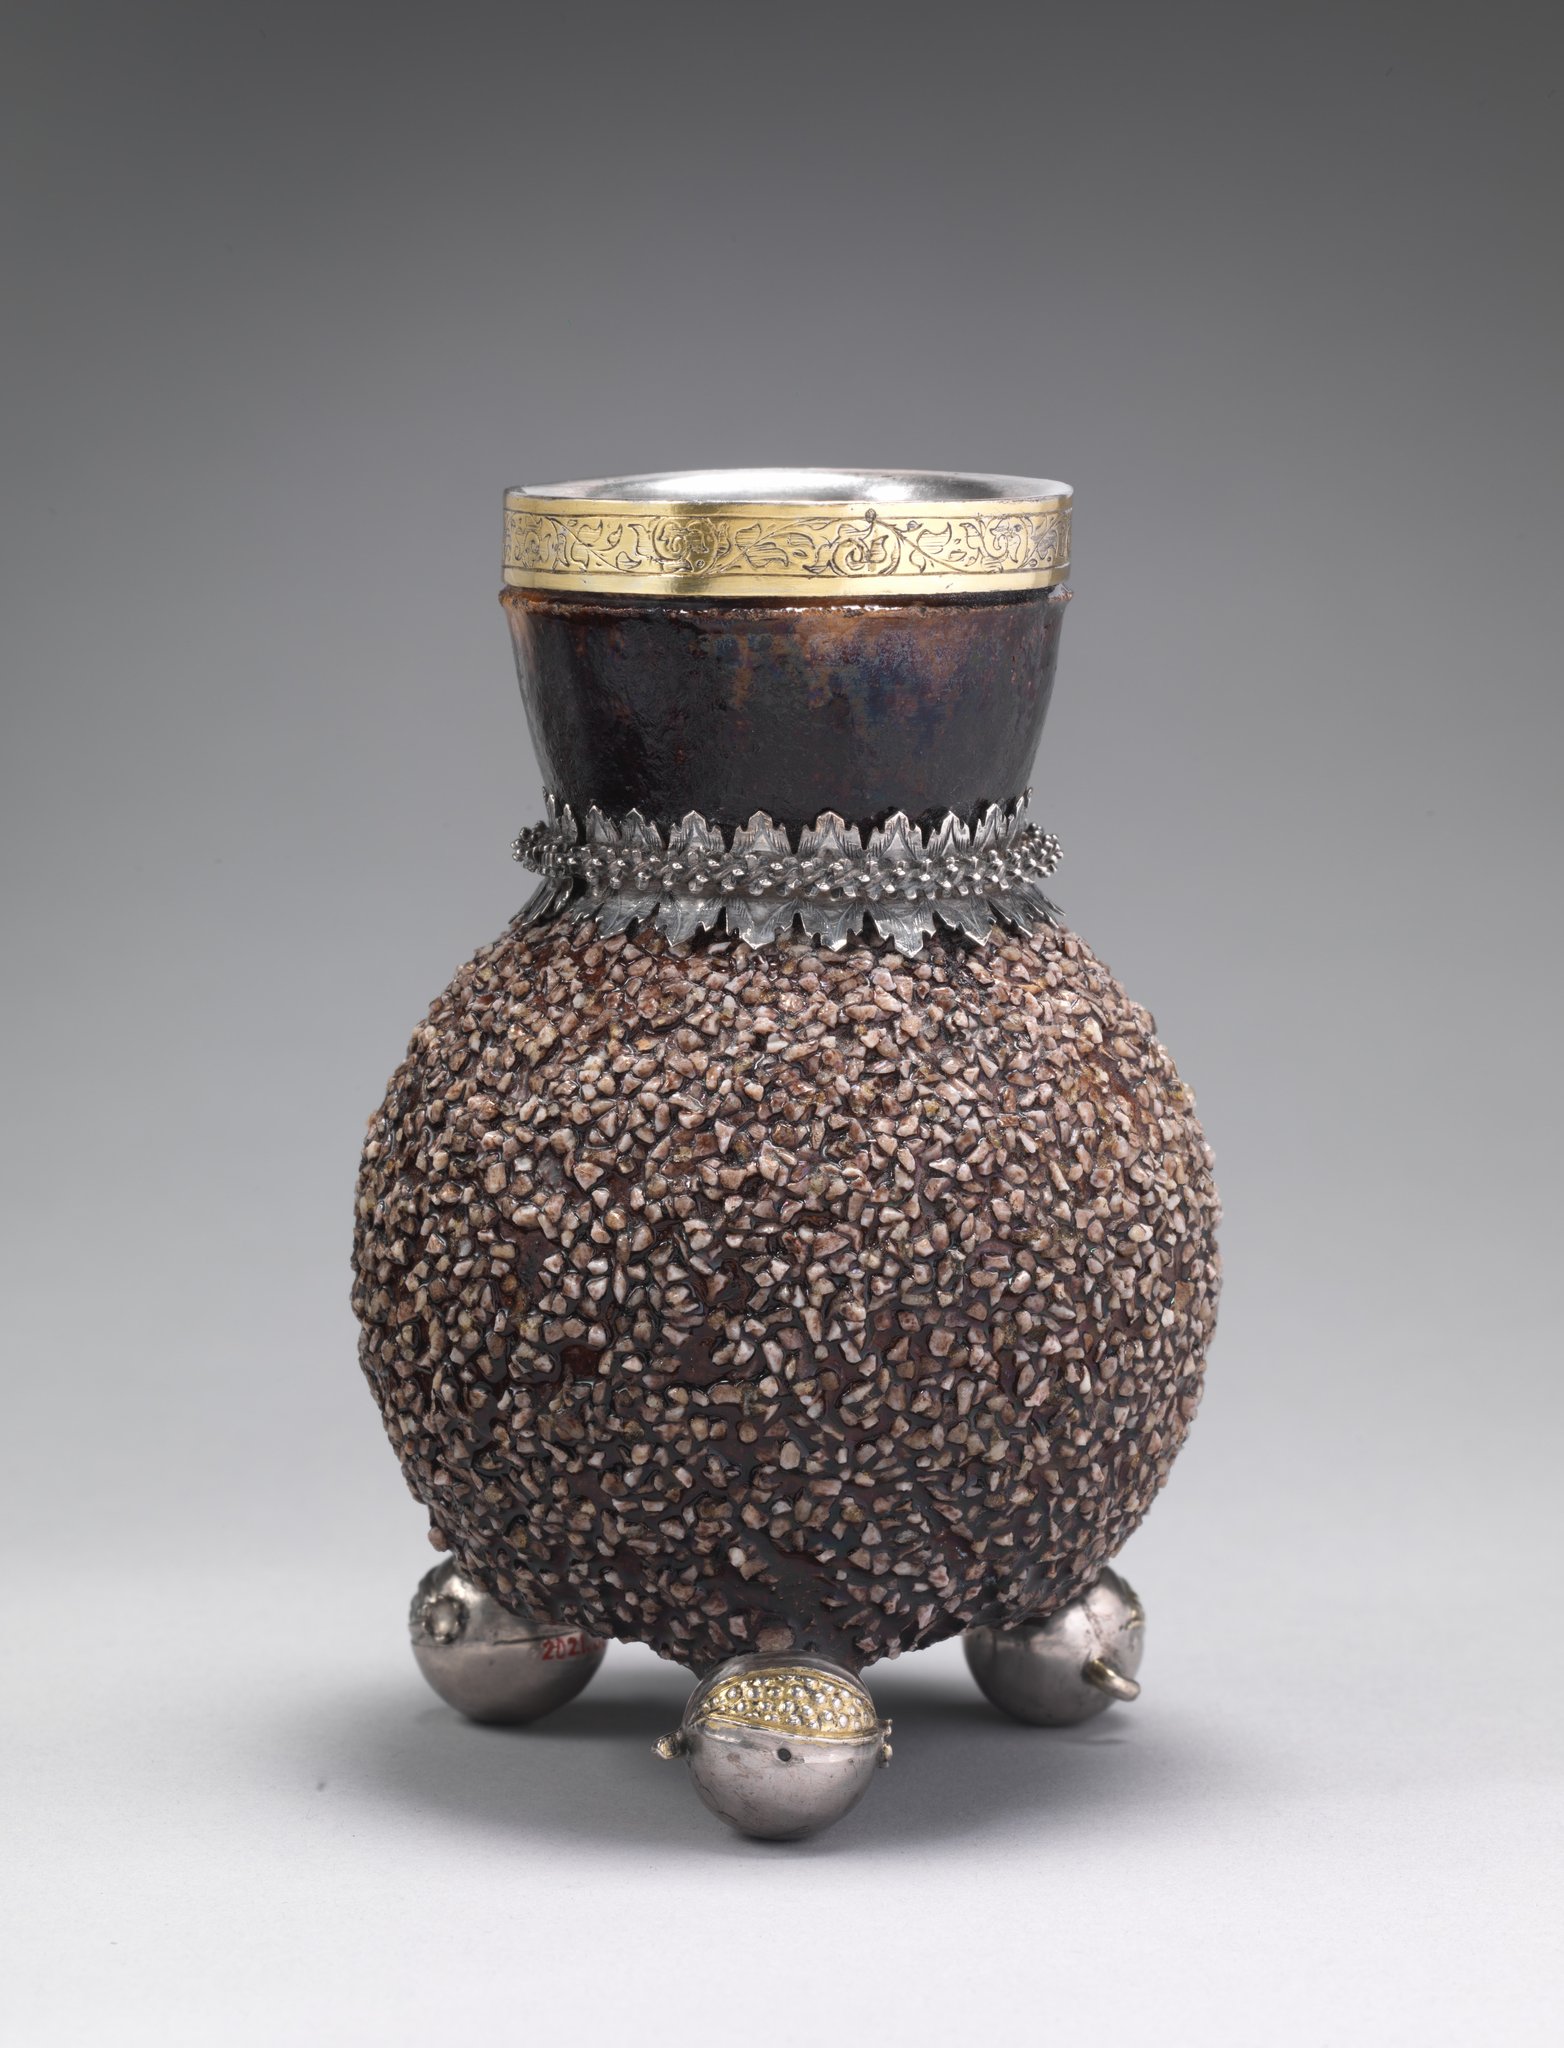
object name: cup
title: Small Drinking Cup (krause)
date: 1530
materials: earthenware, gilt silver, silver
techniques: salt glaze